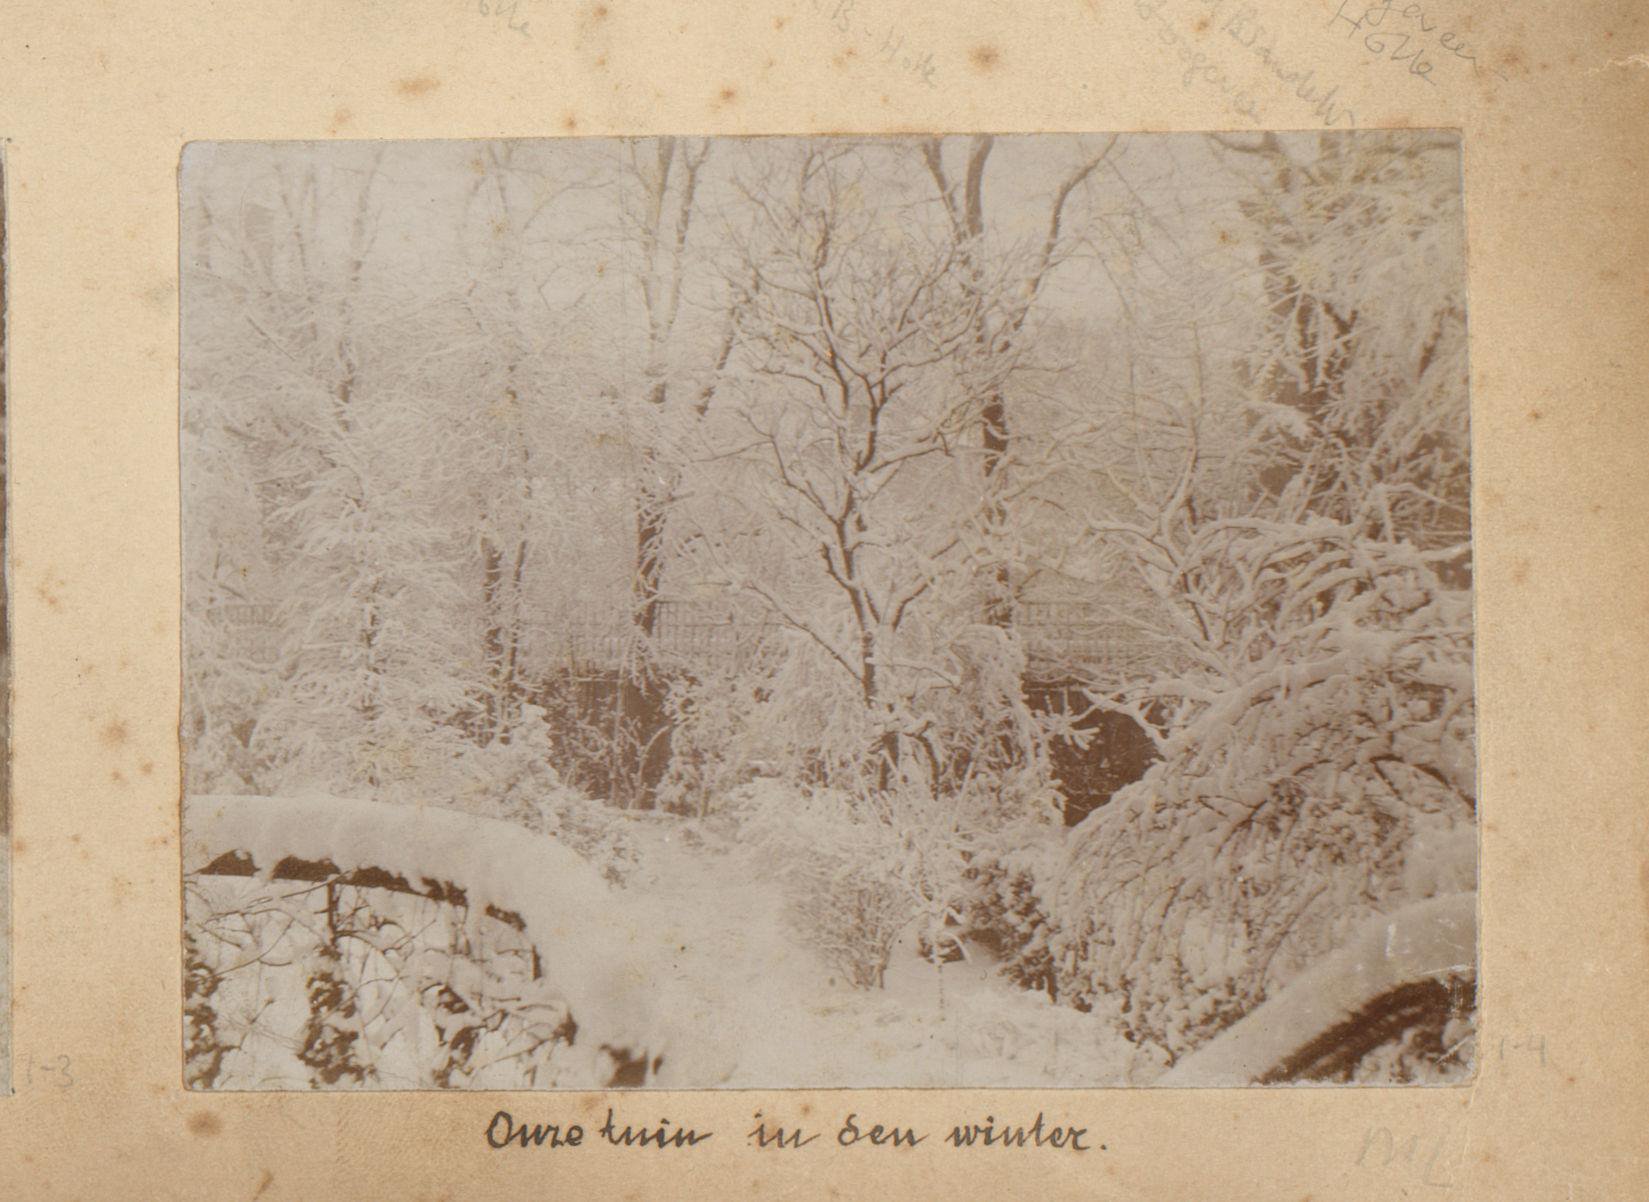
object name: album leaf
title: Onze tuin in den winter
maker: hendrik herman van den berg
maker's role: amateurfotograaf, jurist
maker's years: 1875-1944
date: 1890-1894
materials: paper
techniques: collodion silver print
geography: amsterdam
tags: garden, snow, amsterdam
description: Foto 4 op albumblad 1 uit album "Amsterdam 1890-1894".